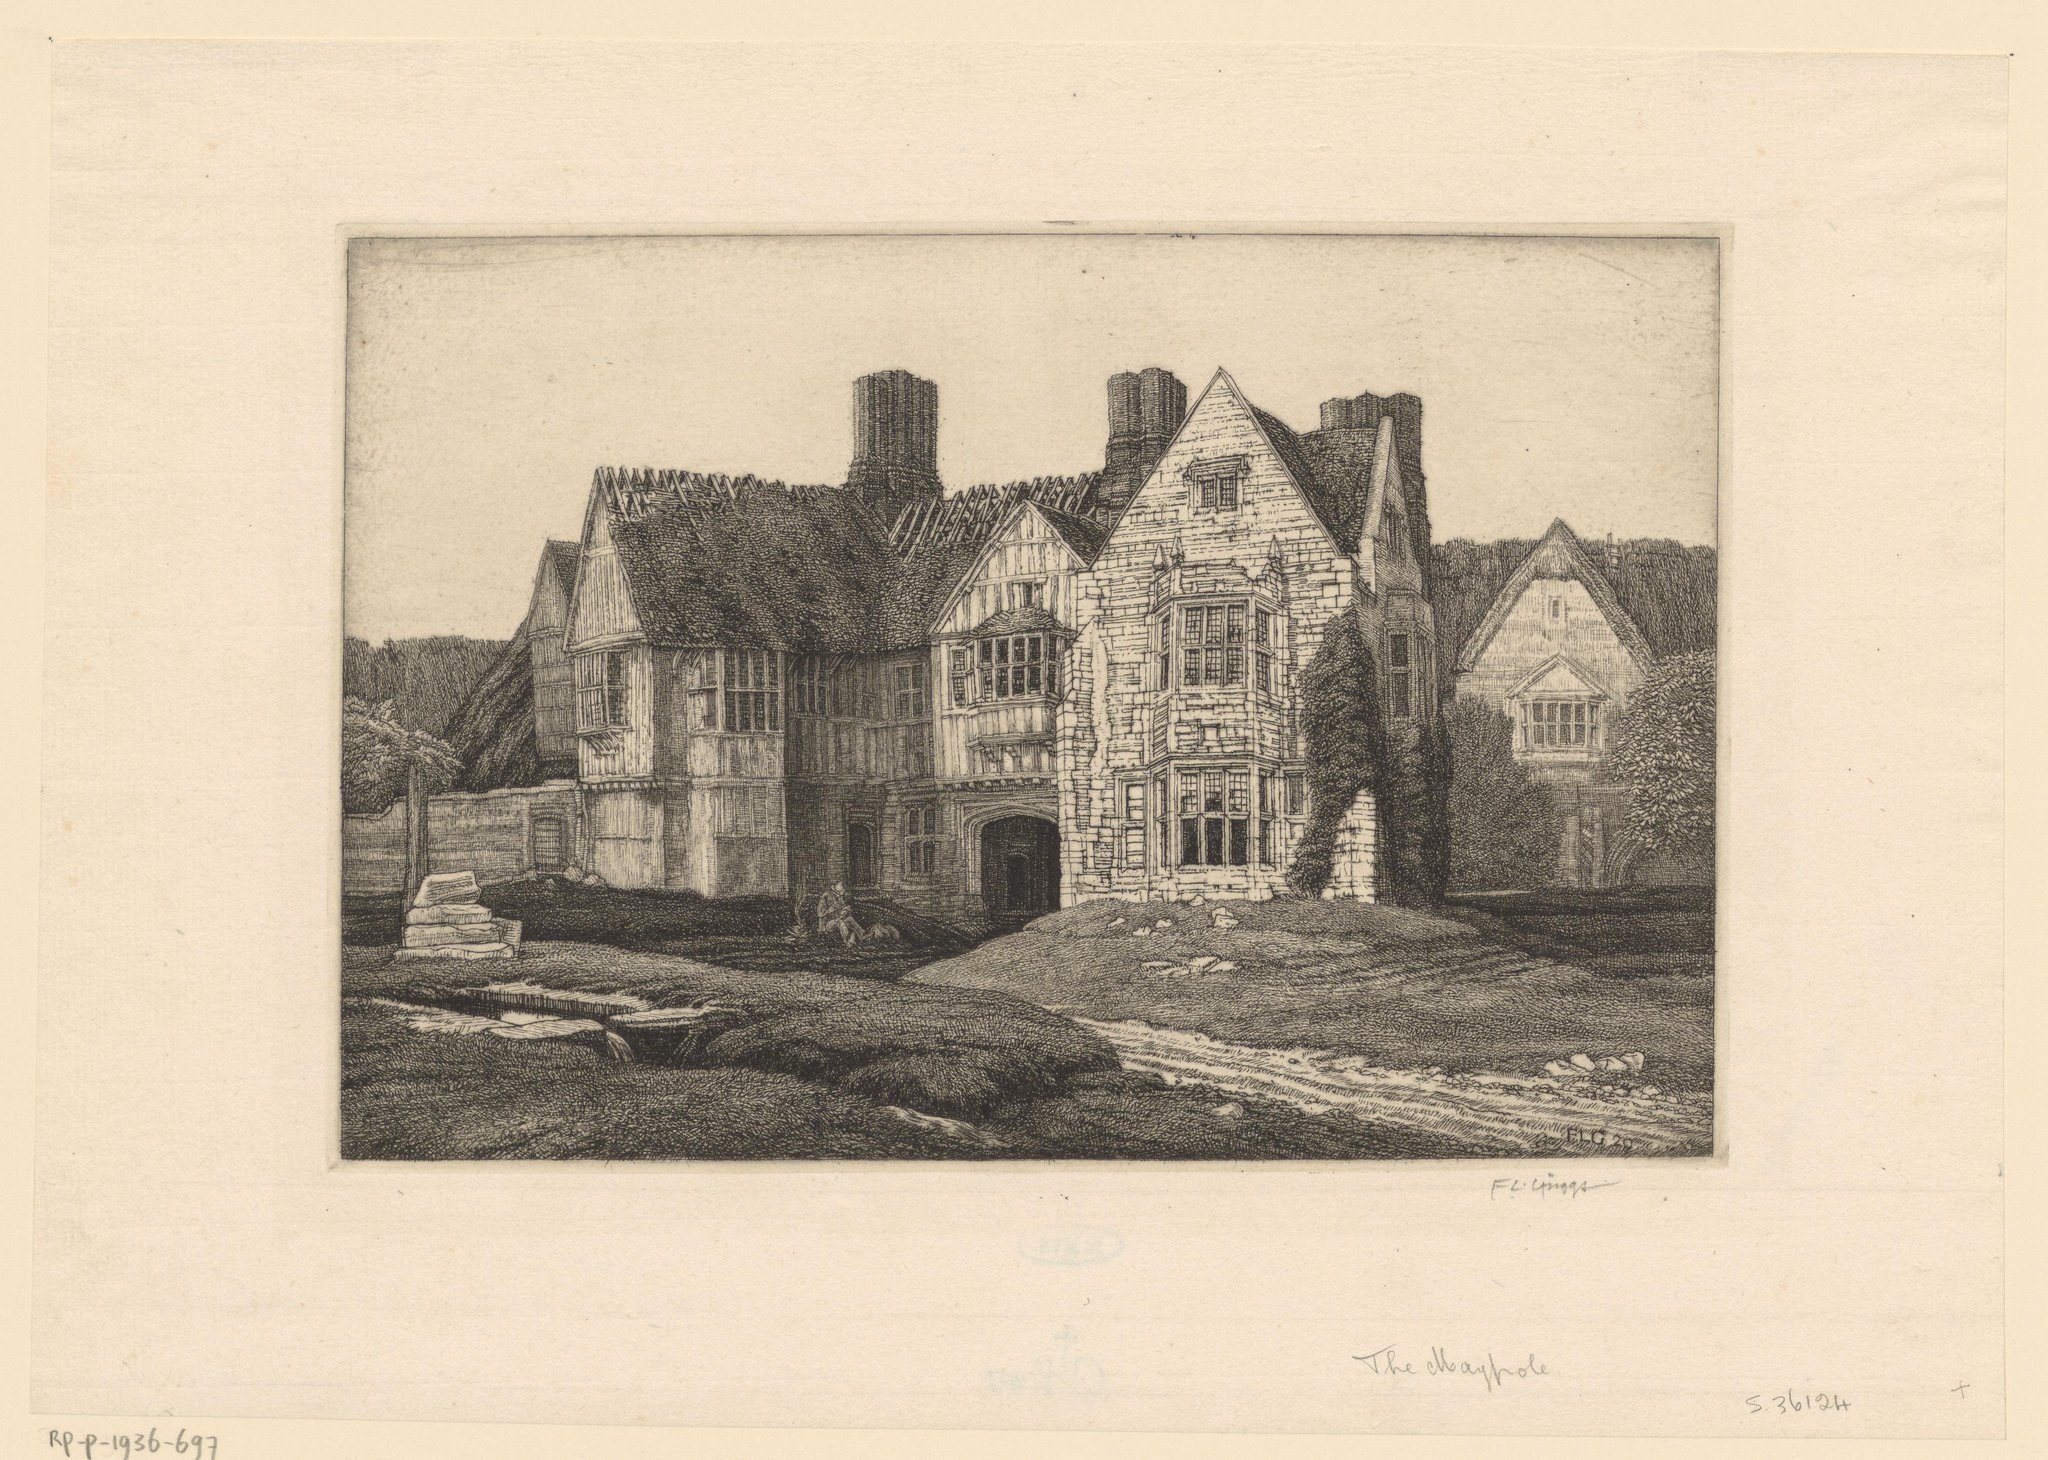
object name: print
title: Man zit voor een vervallen herberg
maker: frederick landseer maur griggs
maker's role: print maker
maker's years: 1876-1938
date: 1929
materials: paper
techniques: etching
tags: hotel, hostelry, inn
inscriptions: collector's mark: Lugt 2228, collector's mark: Lugt 760a, signature: ‘F.L. Griggs’